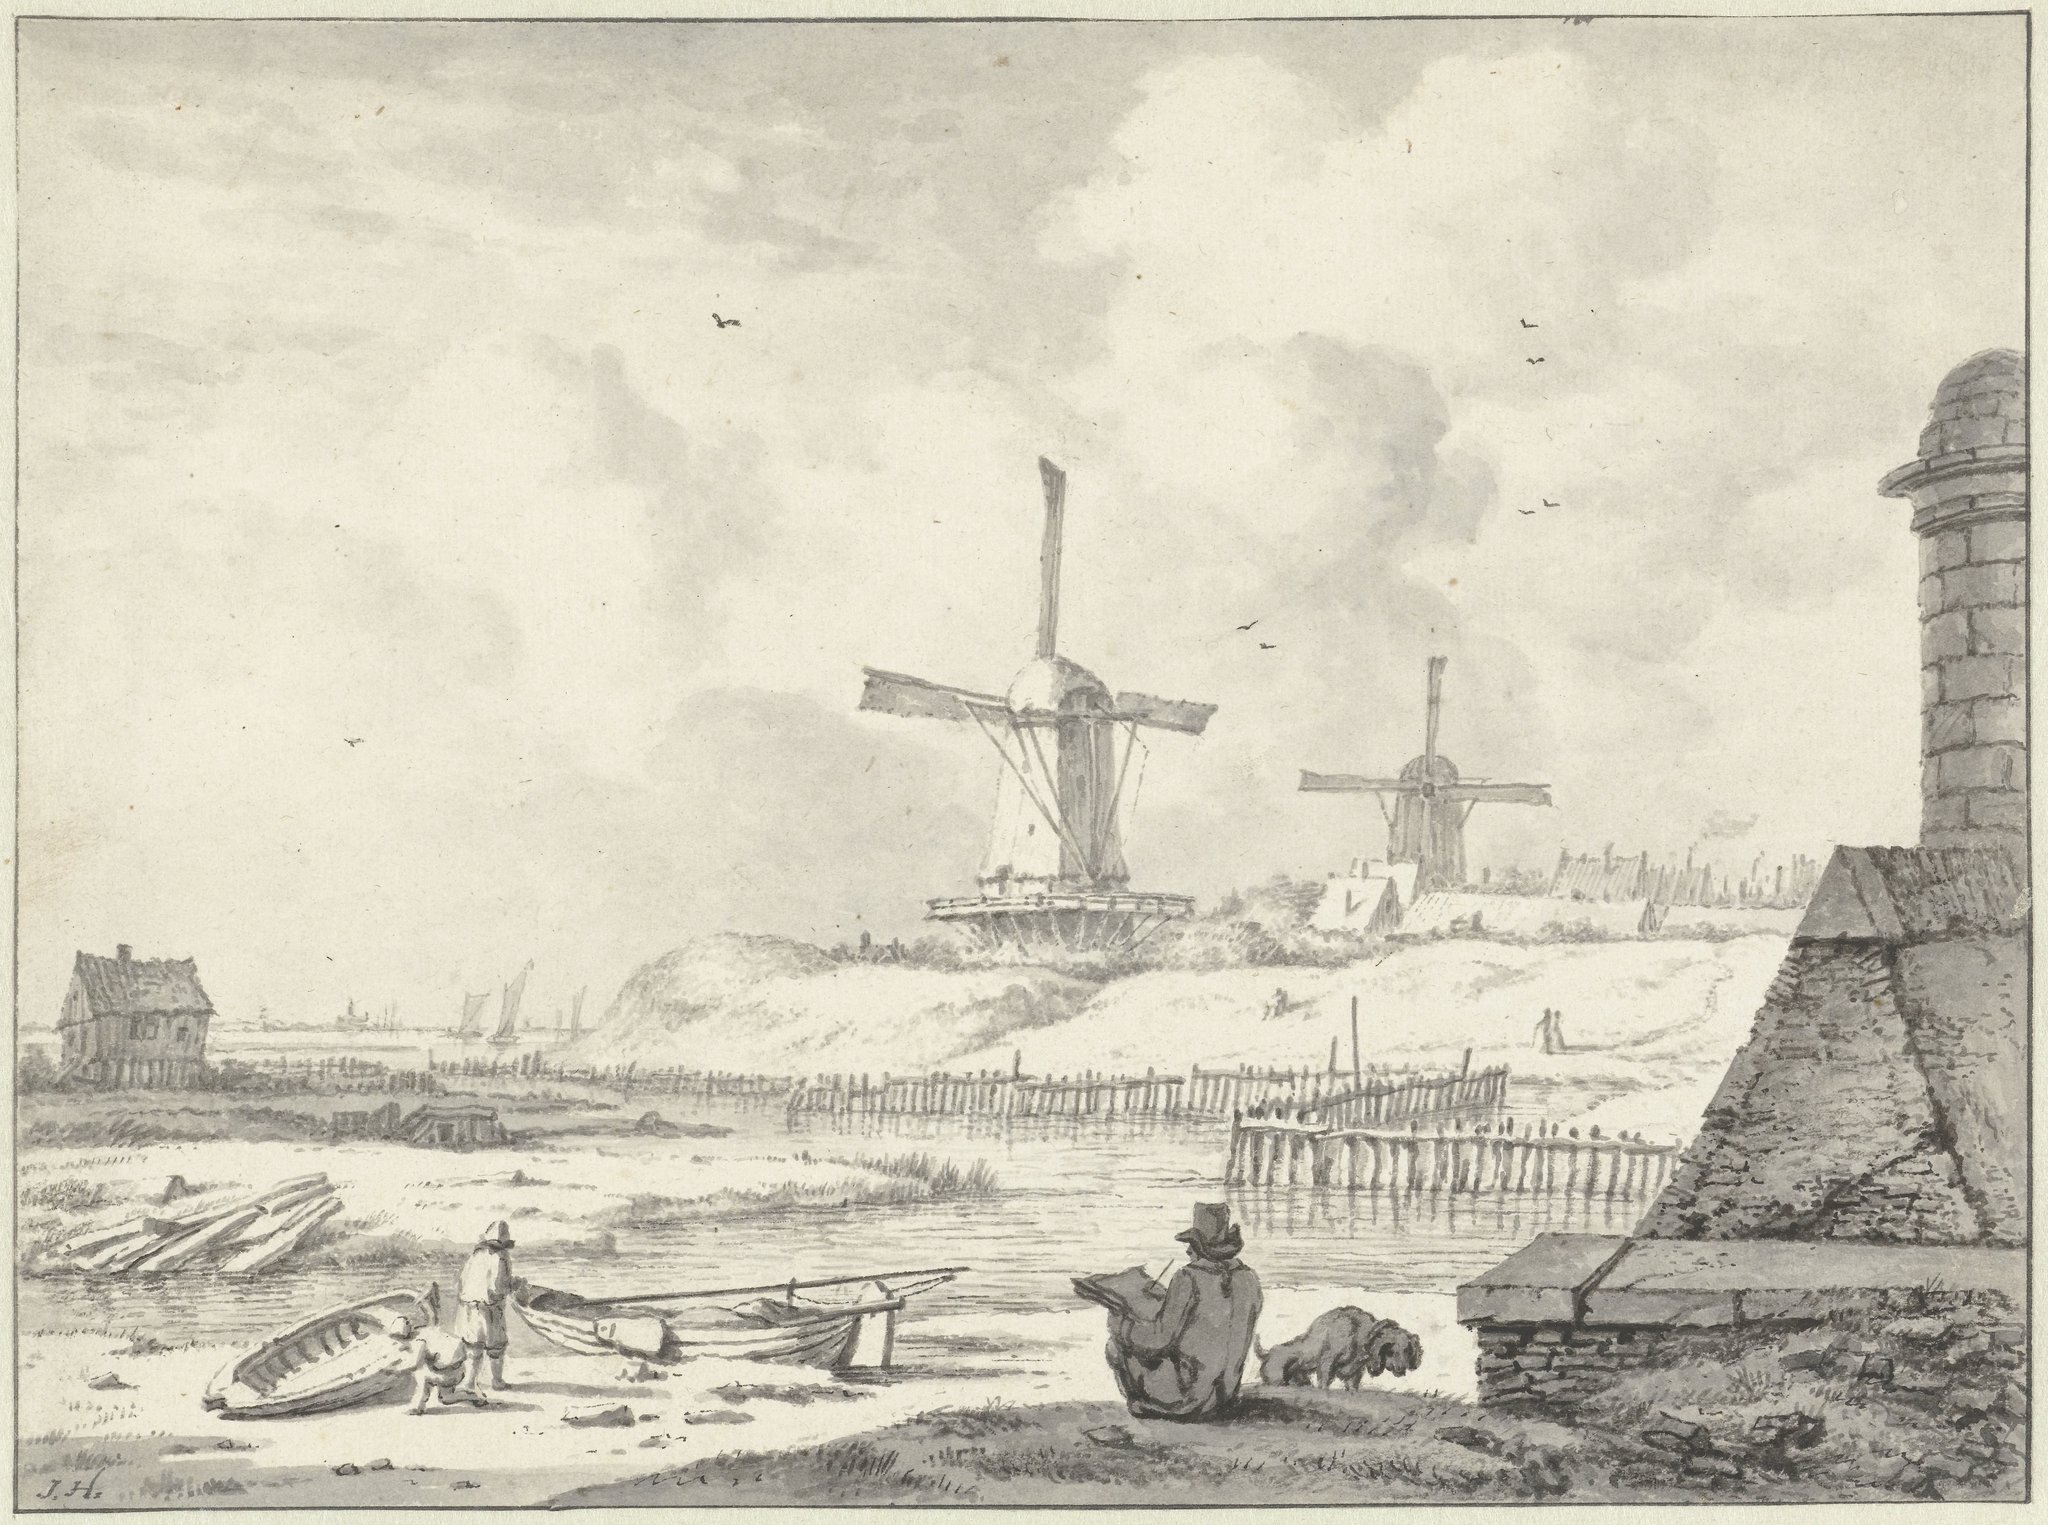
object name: drawing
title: Schetsende tekenaar op de Hoogendijk, buiten de Haarlemmer Poort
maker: jan hulswit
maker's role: draughtsman, painter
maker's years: 1766-1822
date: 1776-1822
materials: ink, paper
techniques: brush, pen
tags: windmill in landscape, draughtsman at work - cc - out of doors, amsterdam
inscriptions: inscription: ‘op de Hoogendijk, Buiten de haarlemmer Poort, siende na de Santhoek’